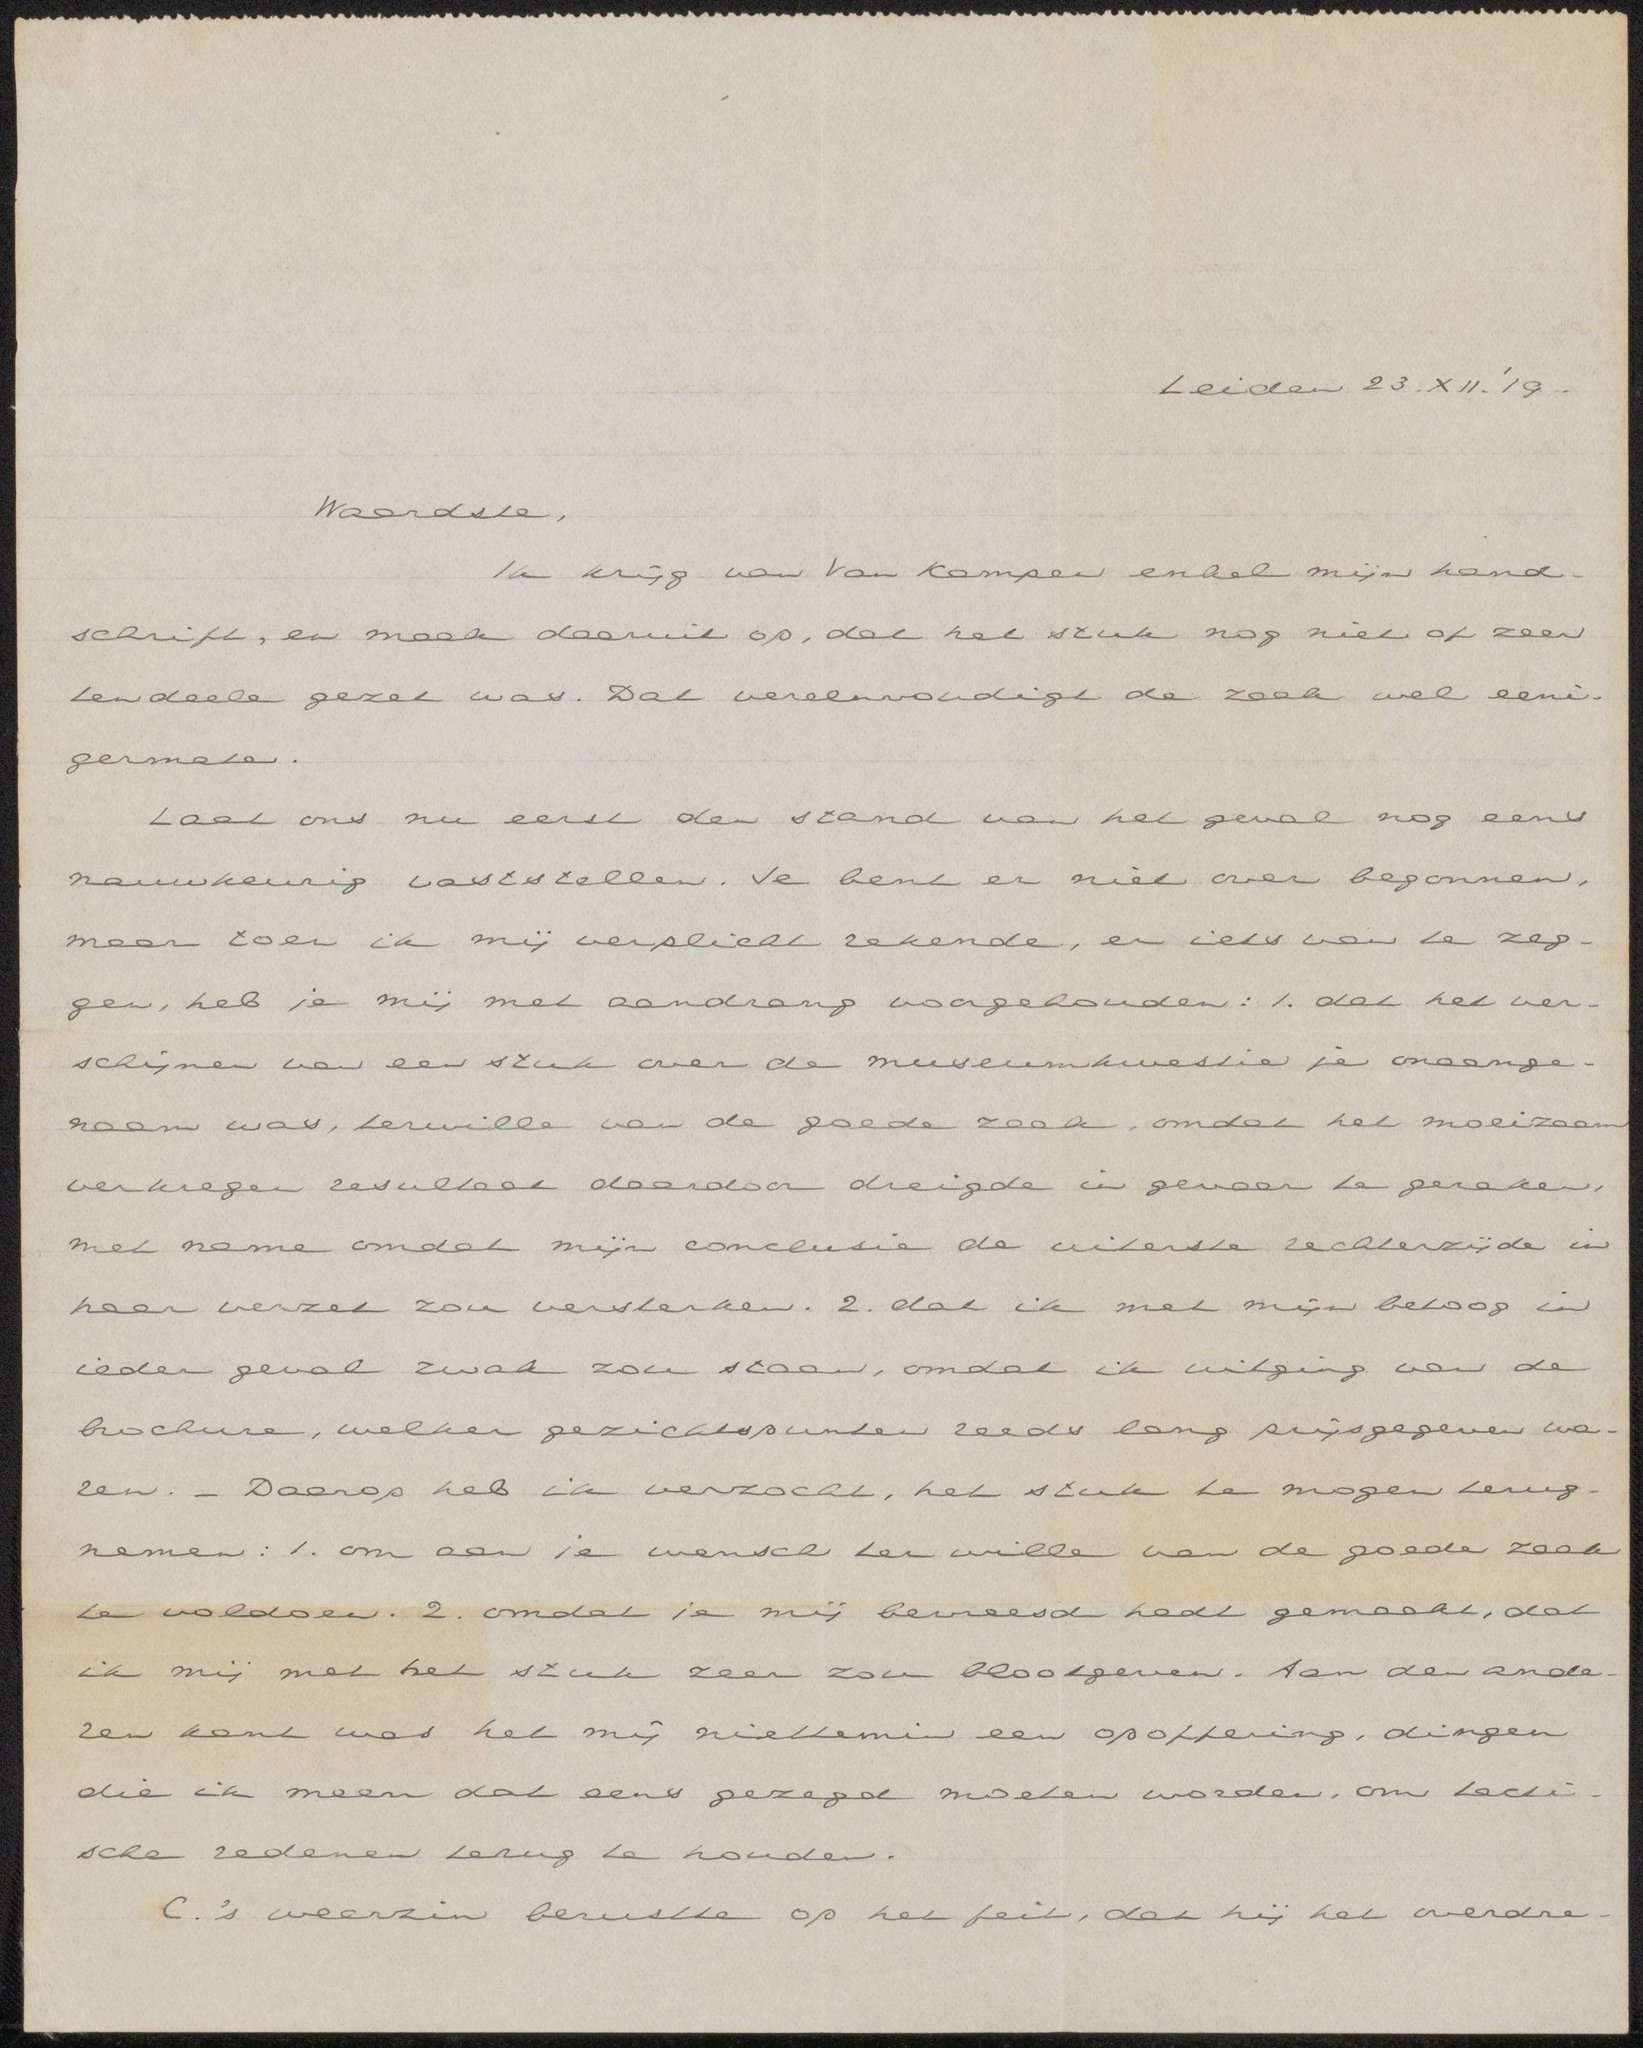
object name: letter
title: Brief aan Jan Veth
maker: johan huizinga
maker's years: 1872-1945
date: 1895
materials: ink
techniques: pen, writing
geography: leipzig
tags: dordrecht, amsterdam, painter, print maker, draughtsman, designer, jan veth, drawing, the graphic arts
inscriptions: collector's mark: ‘RPK’